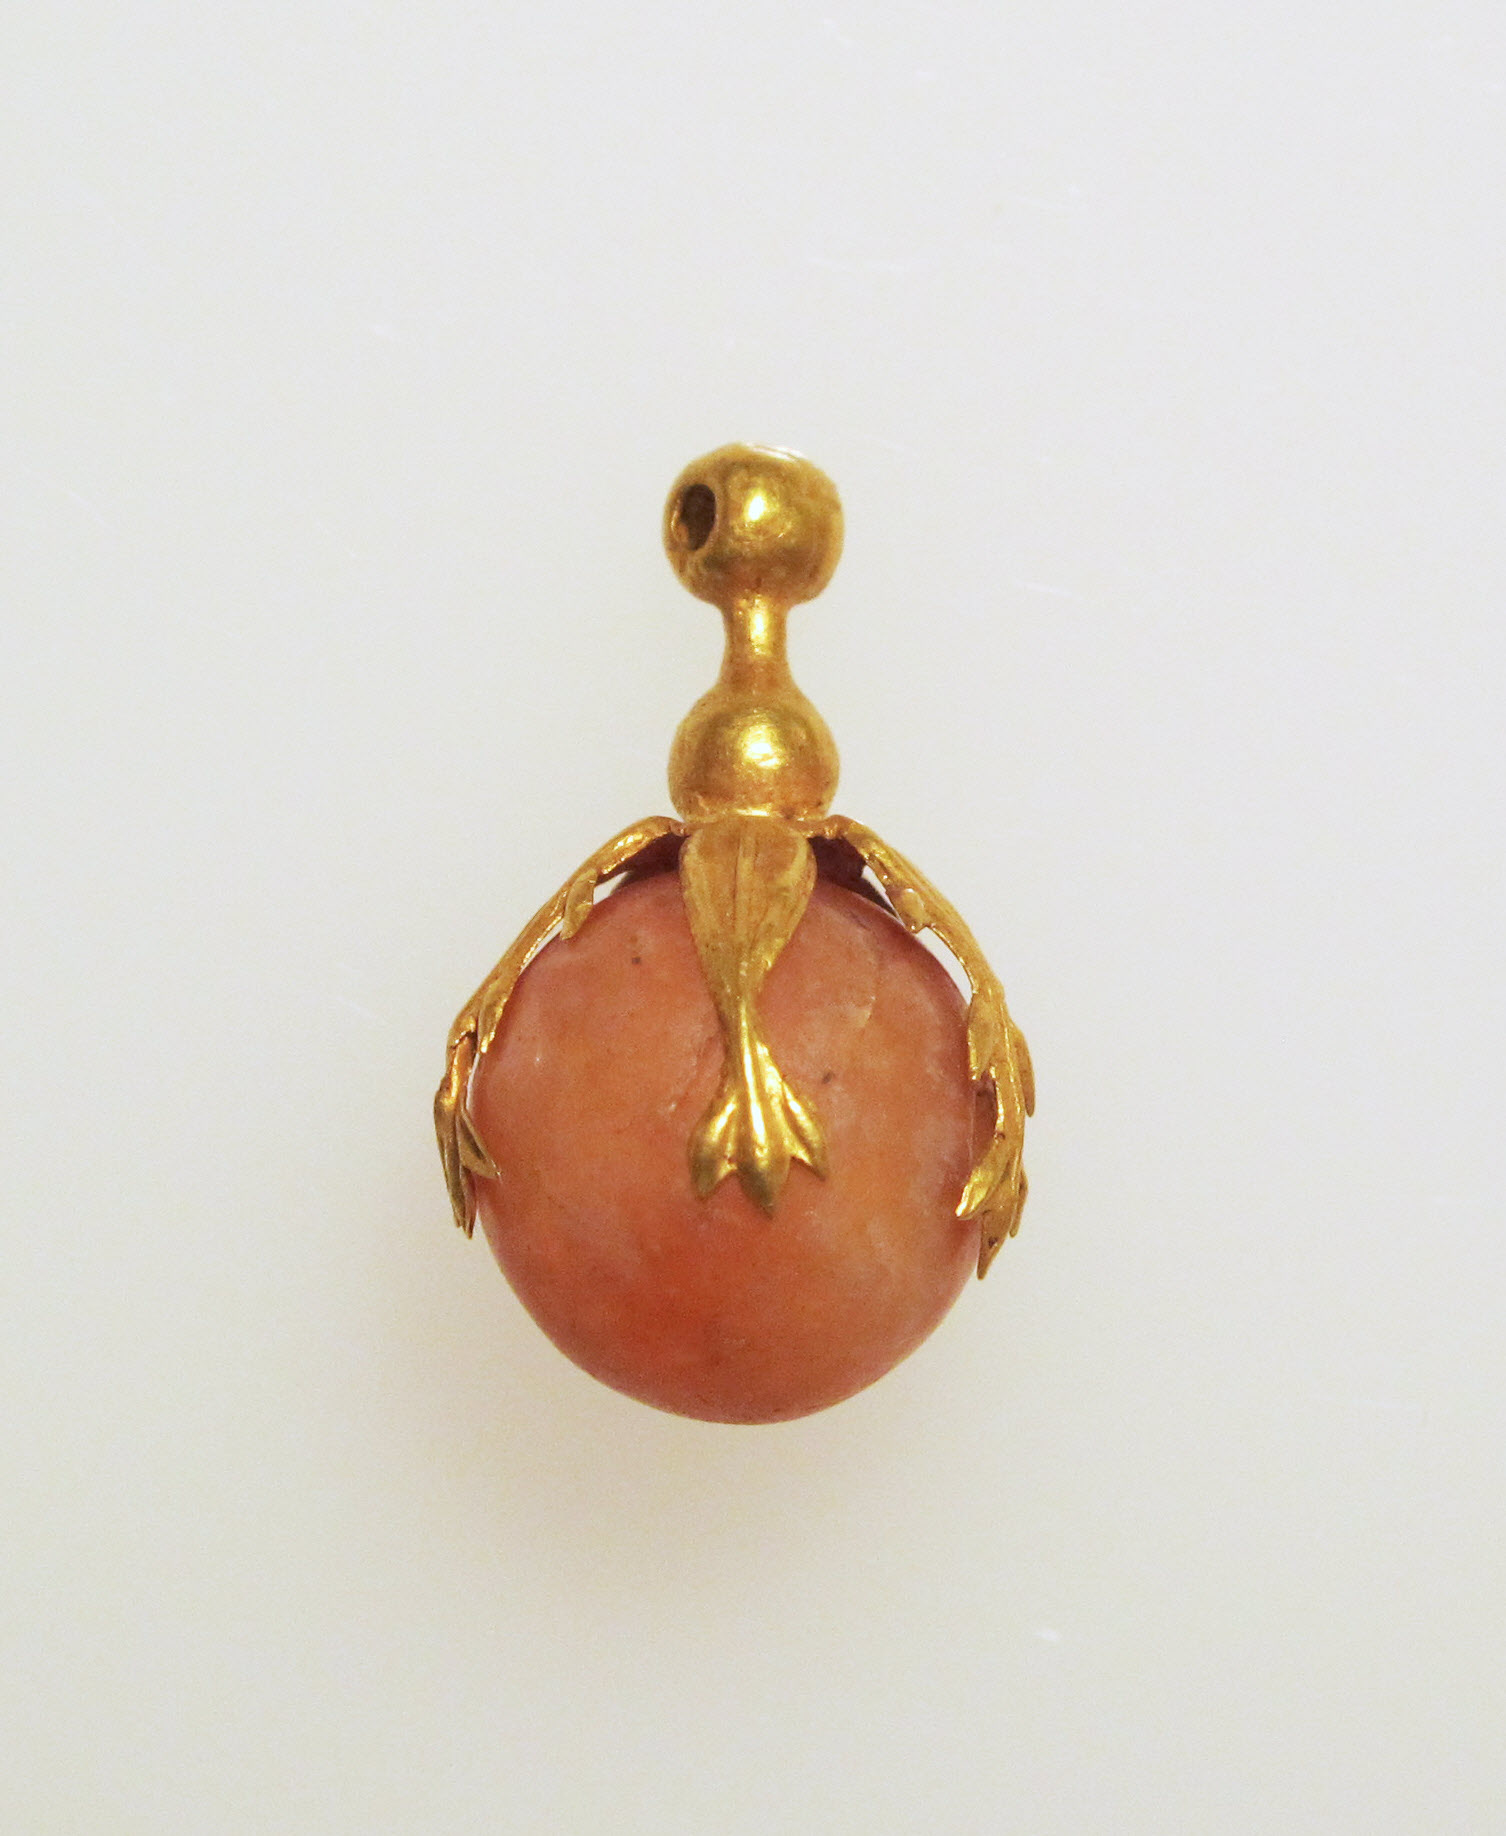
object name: pendant with rose bud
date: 7000 BCE-330 CE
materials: gold